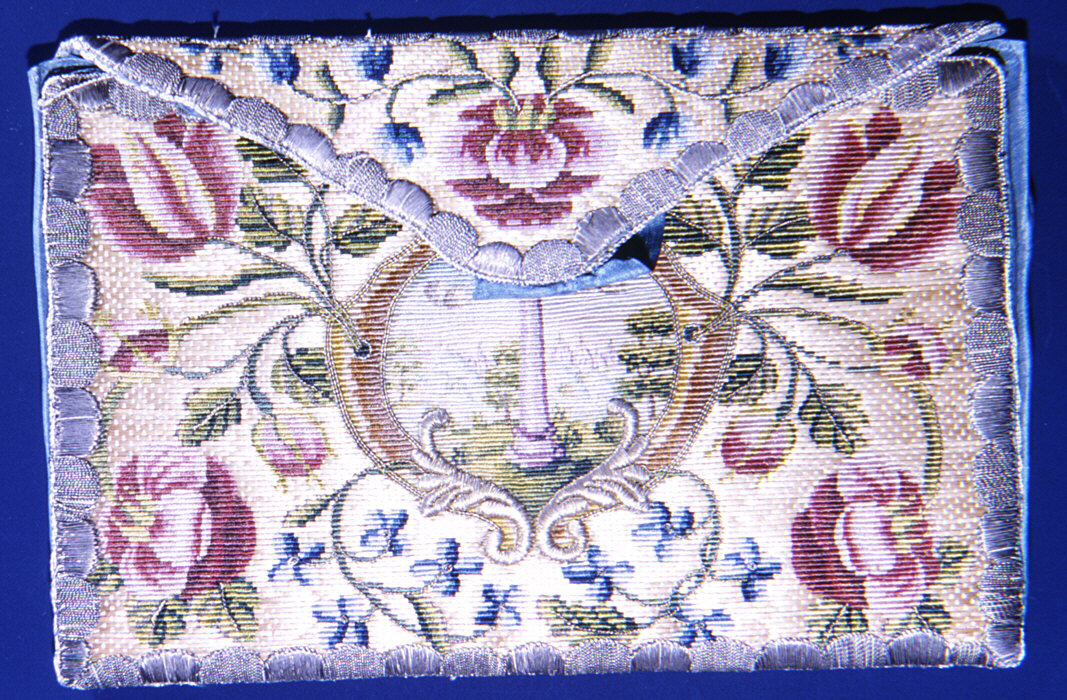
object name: étui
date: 1701-1800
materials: metal, metal thread, silk, fiber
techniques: lining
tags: flowers